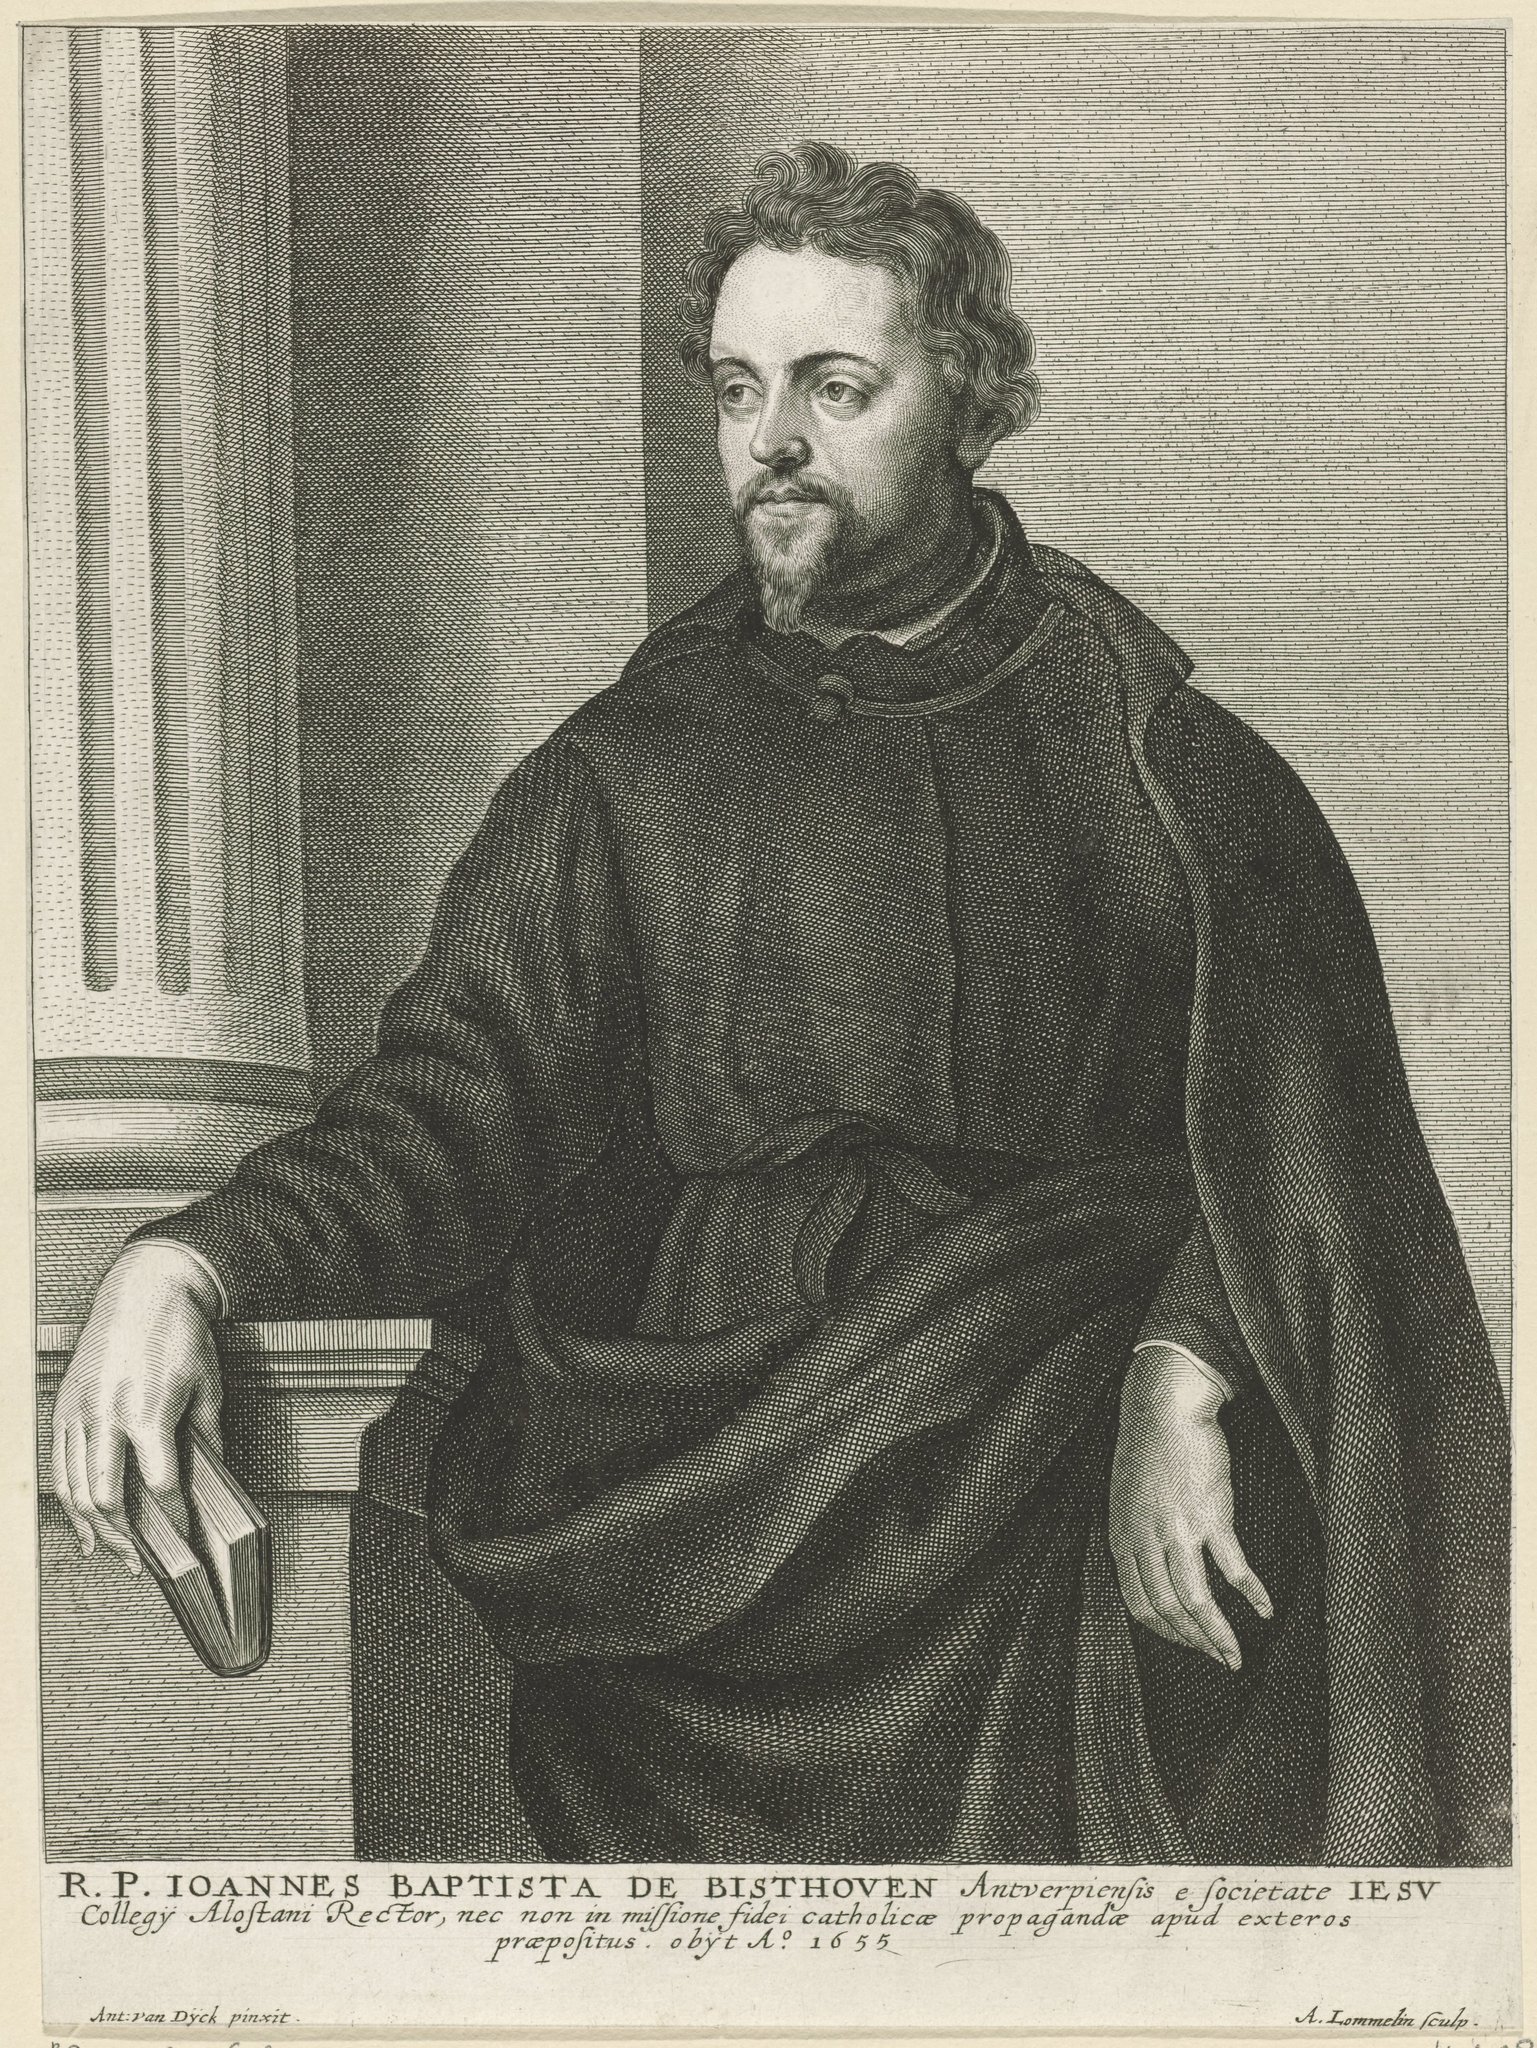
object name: print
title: Portret van Jan Baptist van Bisthoven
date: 1630-1677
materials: paper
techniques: engraving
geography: antwerp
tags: rector, jezuïet, jan baptist van bisthoven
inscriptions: collector's mark: Lugt 240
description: Portret van Jan Baptist van Bisthoven, Jezuïet en rector van het college te Aalst.